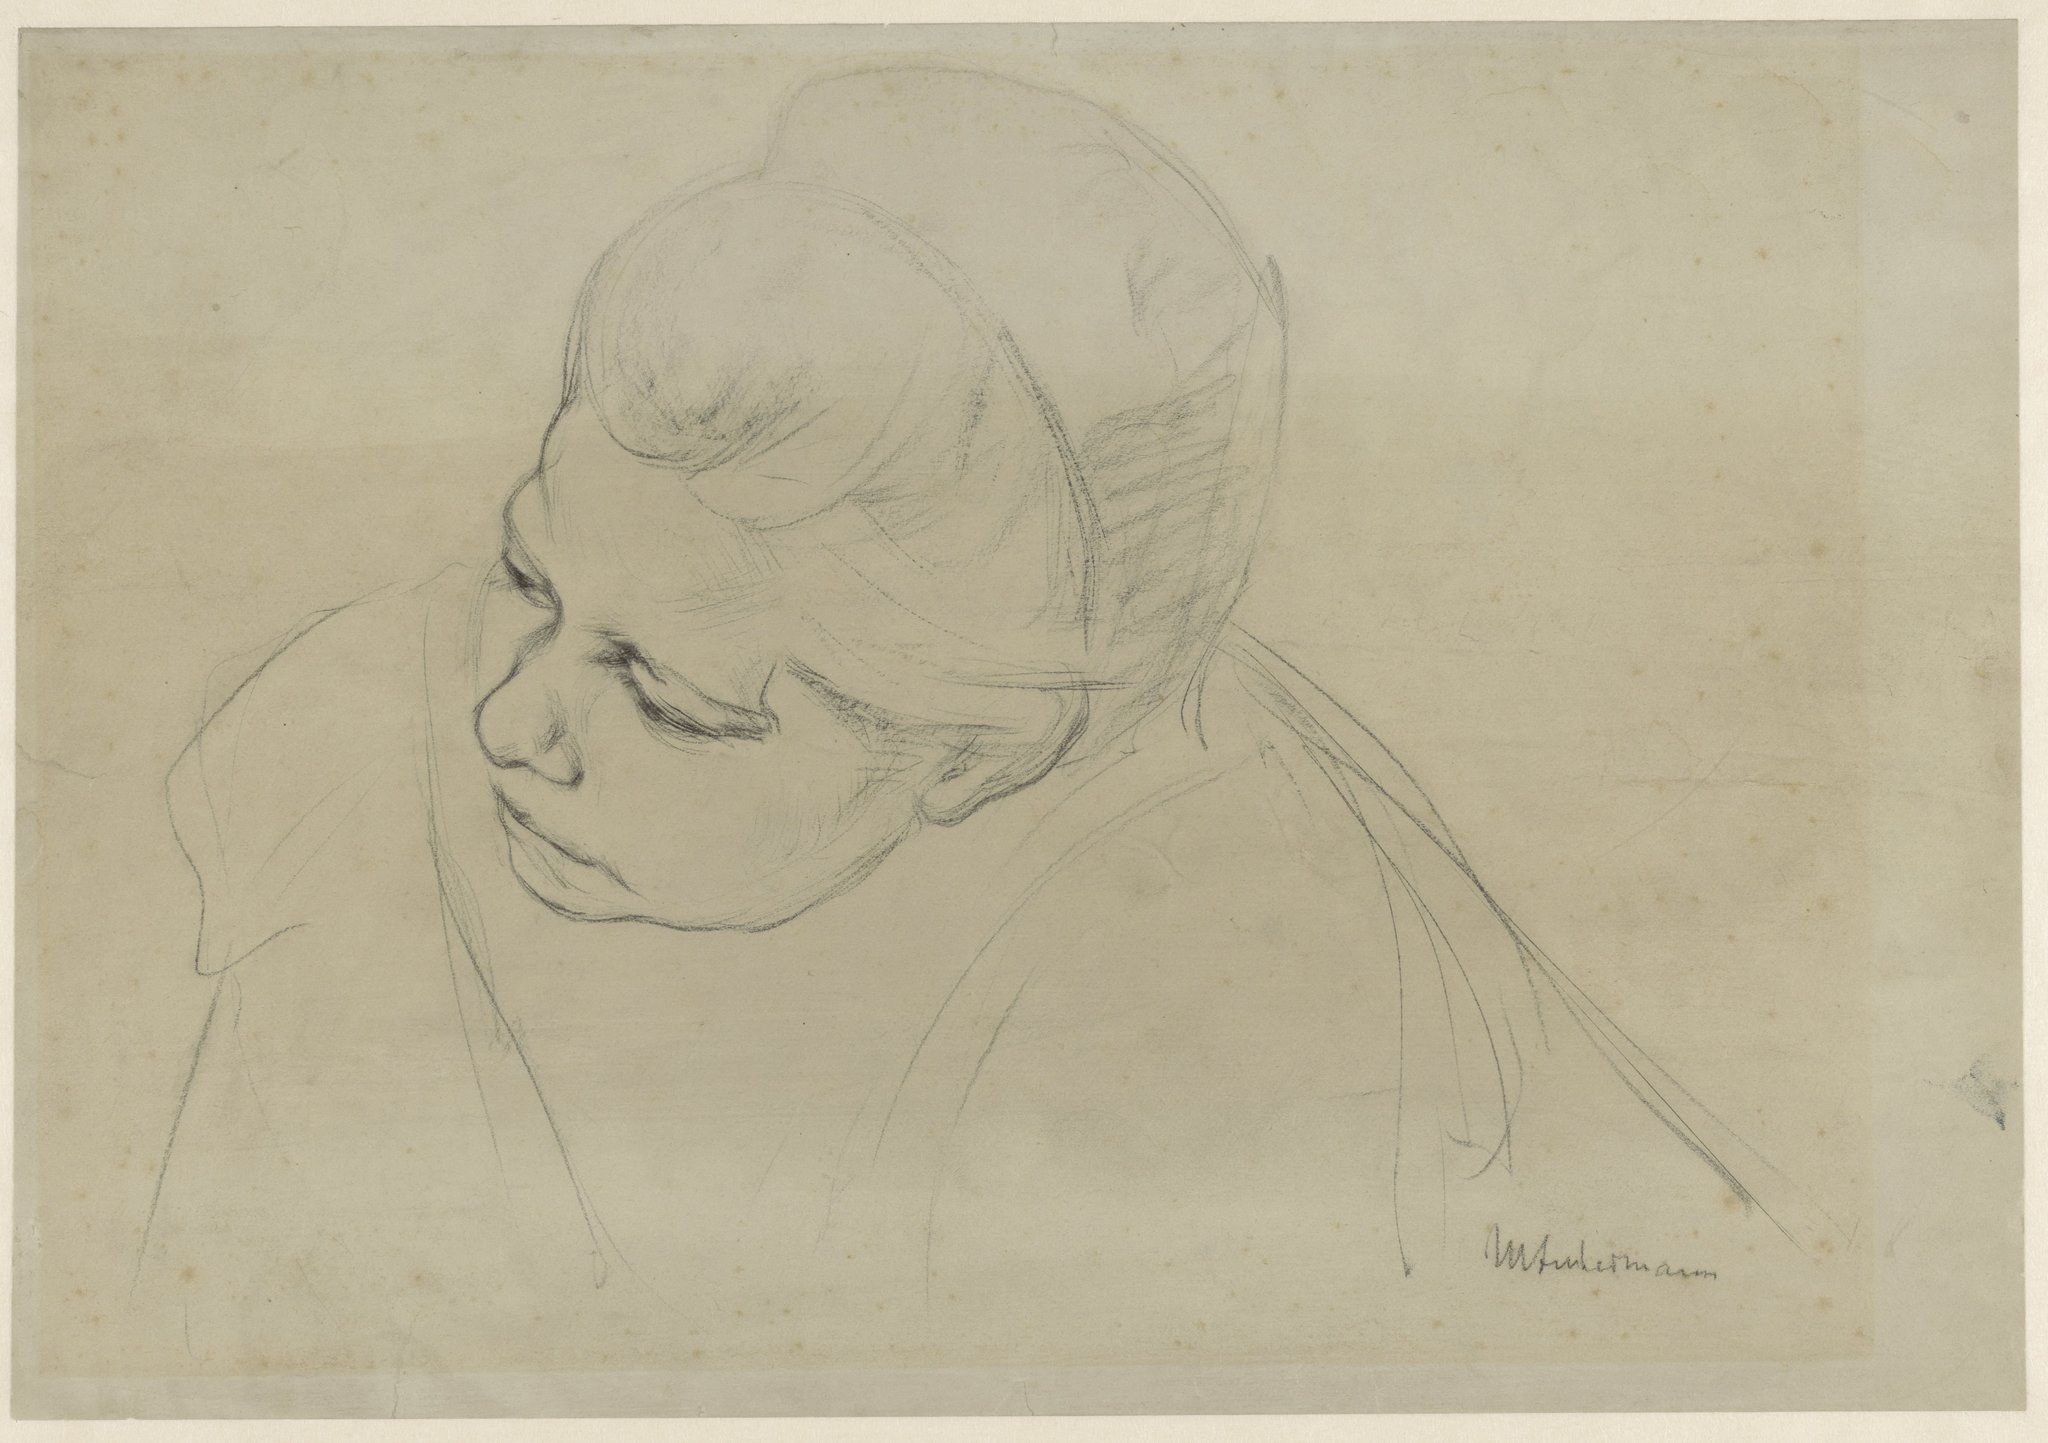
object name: drawing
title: Studie van een voorovergebogen vrouwenfiguur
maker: max liebermann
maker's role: draughtsman, print maker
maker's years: 1847-1935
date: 1857-1935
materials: chalk, paper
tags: leaning forward - aa - female human figure